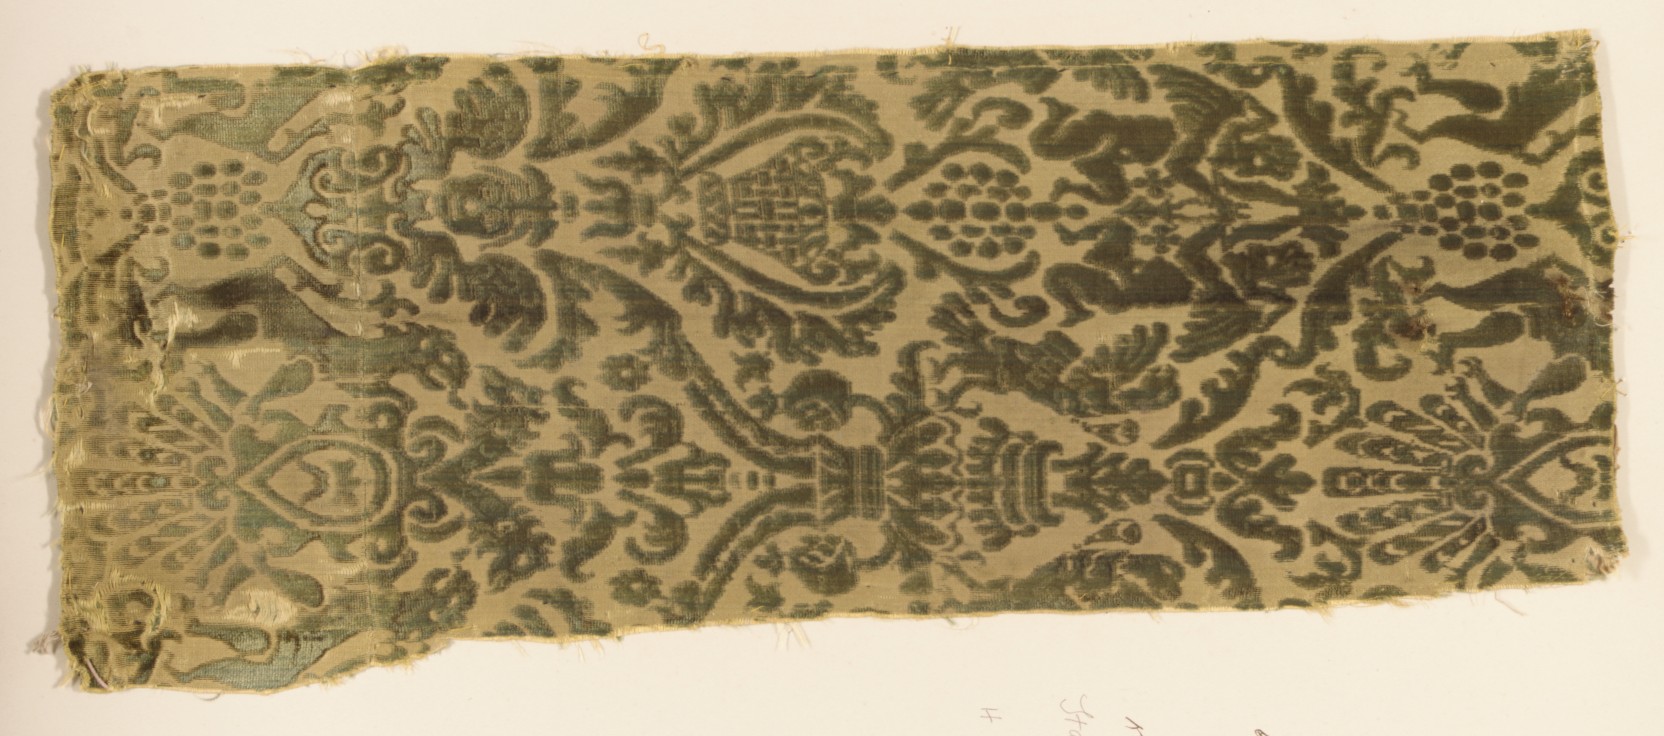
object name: fragment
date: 1501-1600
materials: silk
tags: flowers,leaves